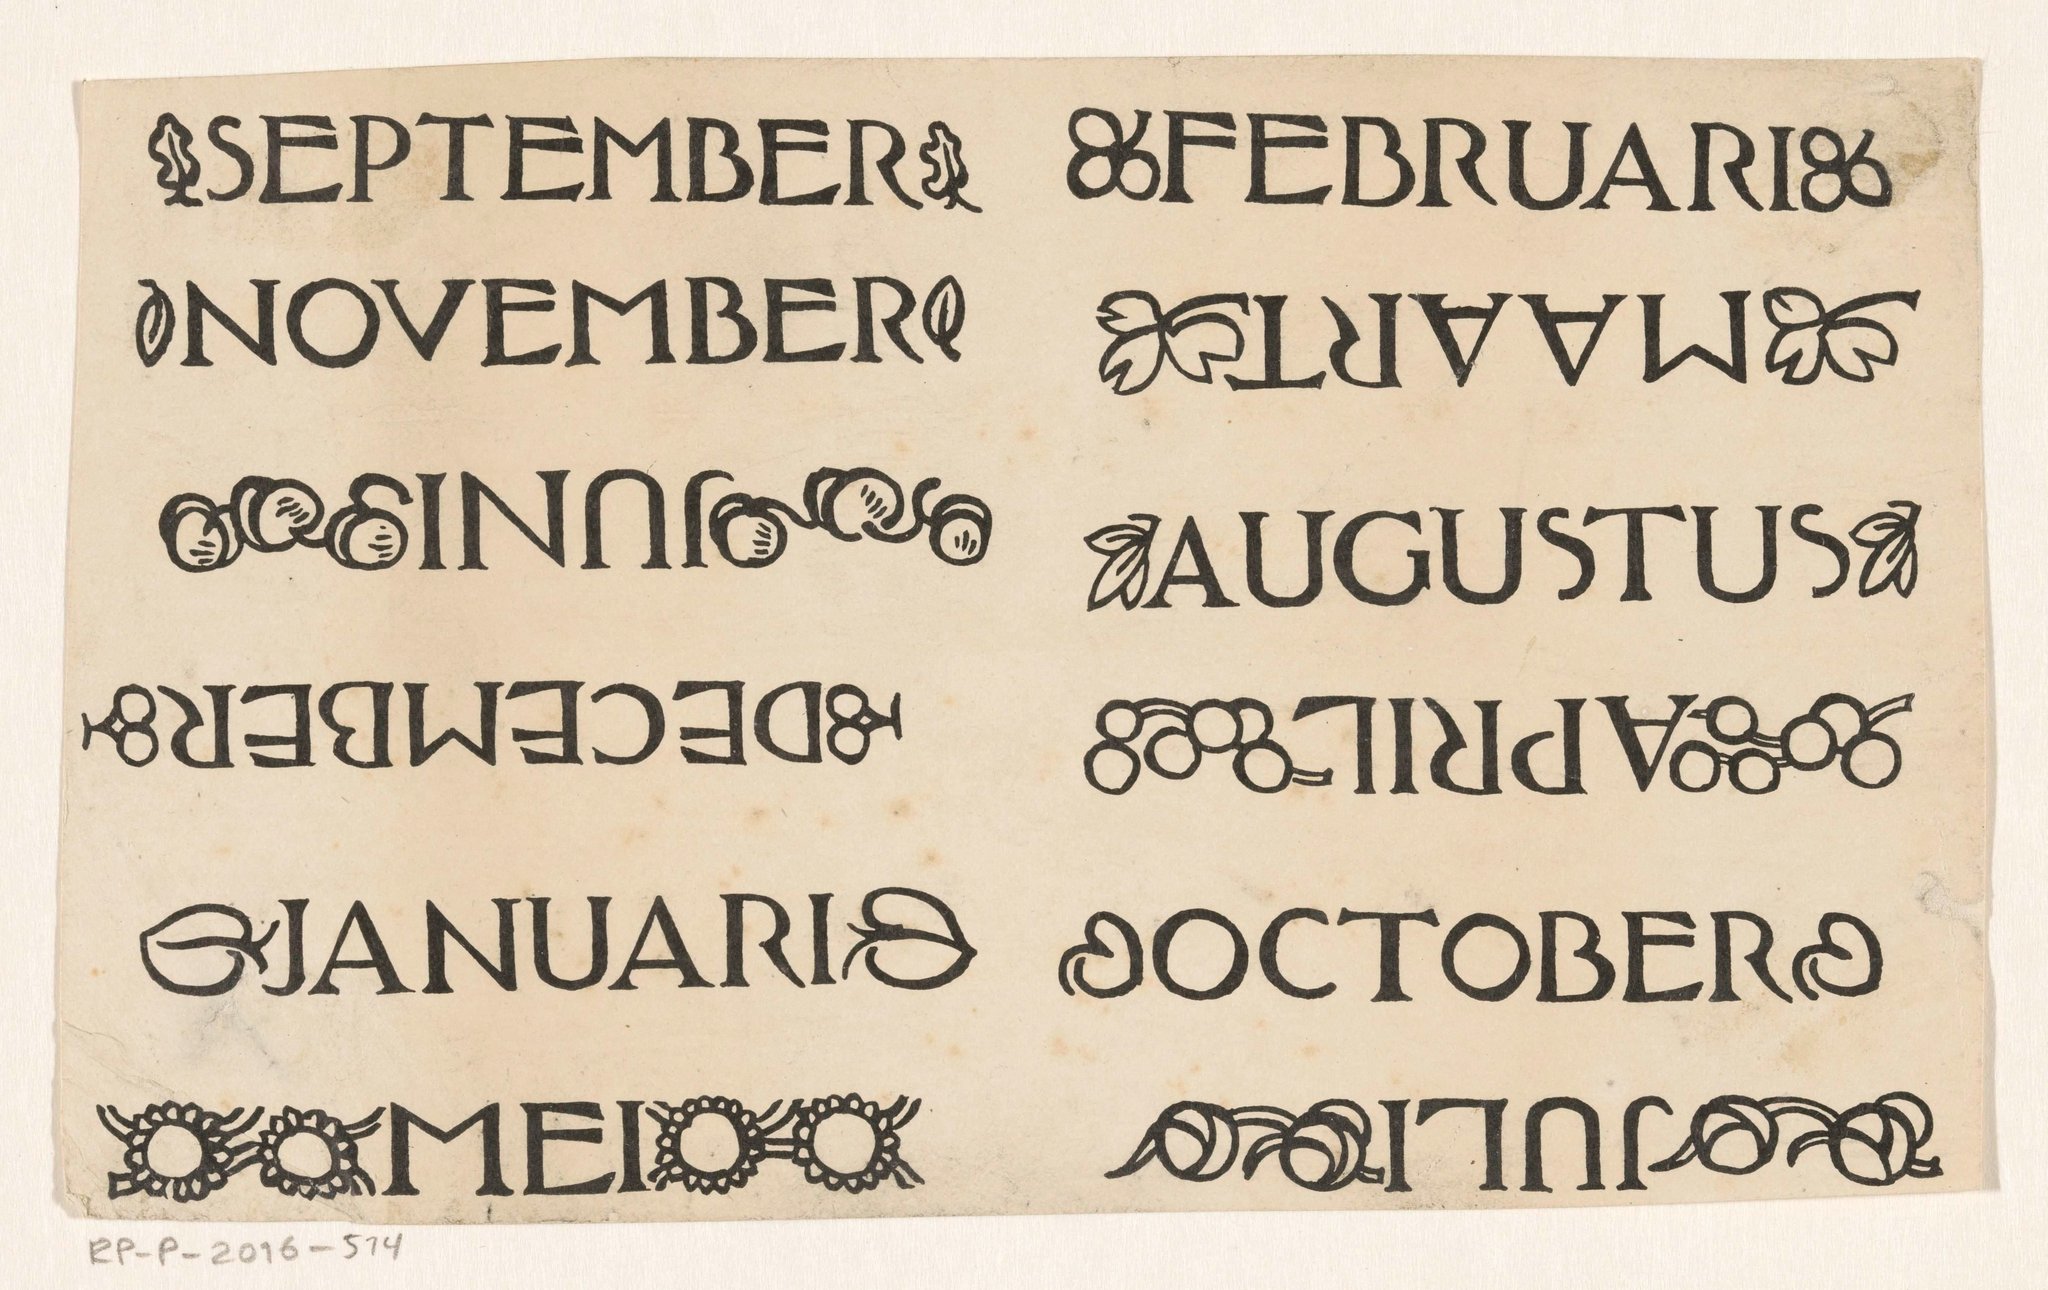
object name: photomechanical print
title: Maanden van het jaar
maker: Anonymous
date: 1904-1919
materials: paper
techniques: printing block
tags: foliage, tendrils, branches ~ ornament, flowers ~ ornament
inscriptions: collector's mark: Lugt 2228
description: Vermoedelijk een ontwerp voor: Gezelle, Guido. Motto-album. Amsterdam: Veen, 1904 en 1919.